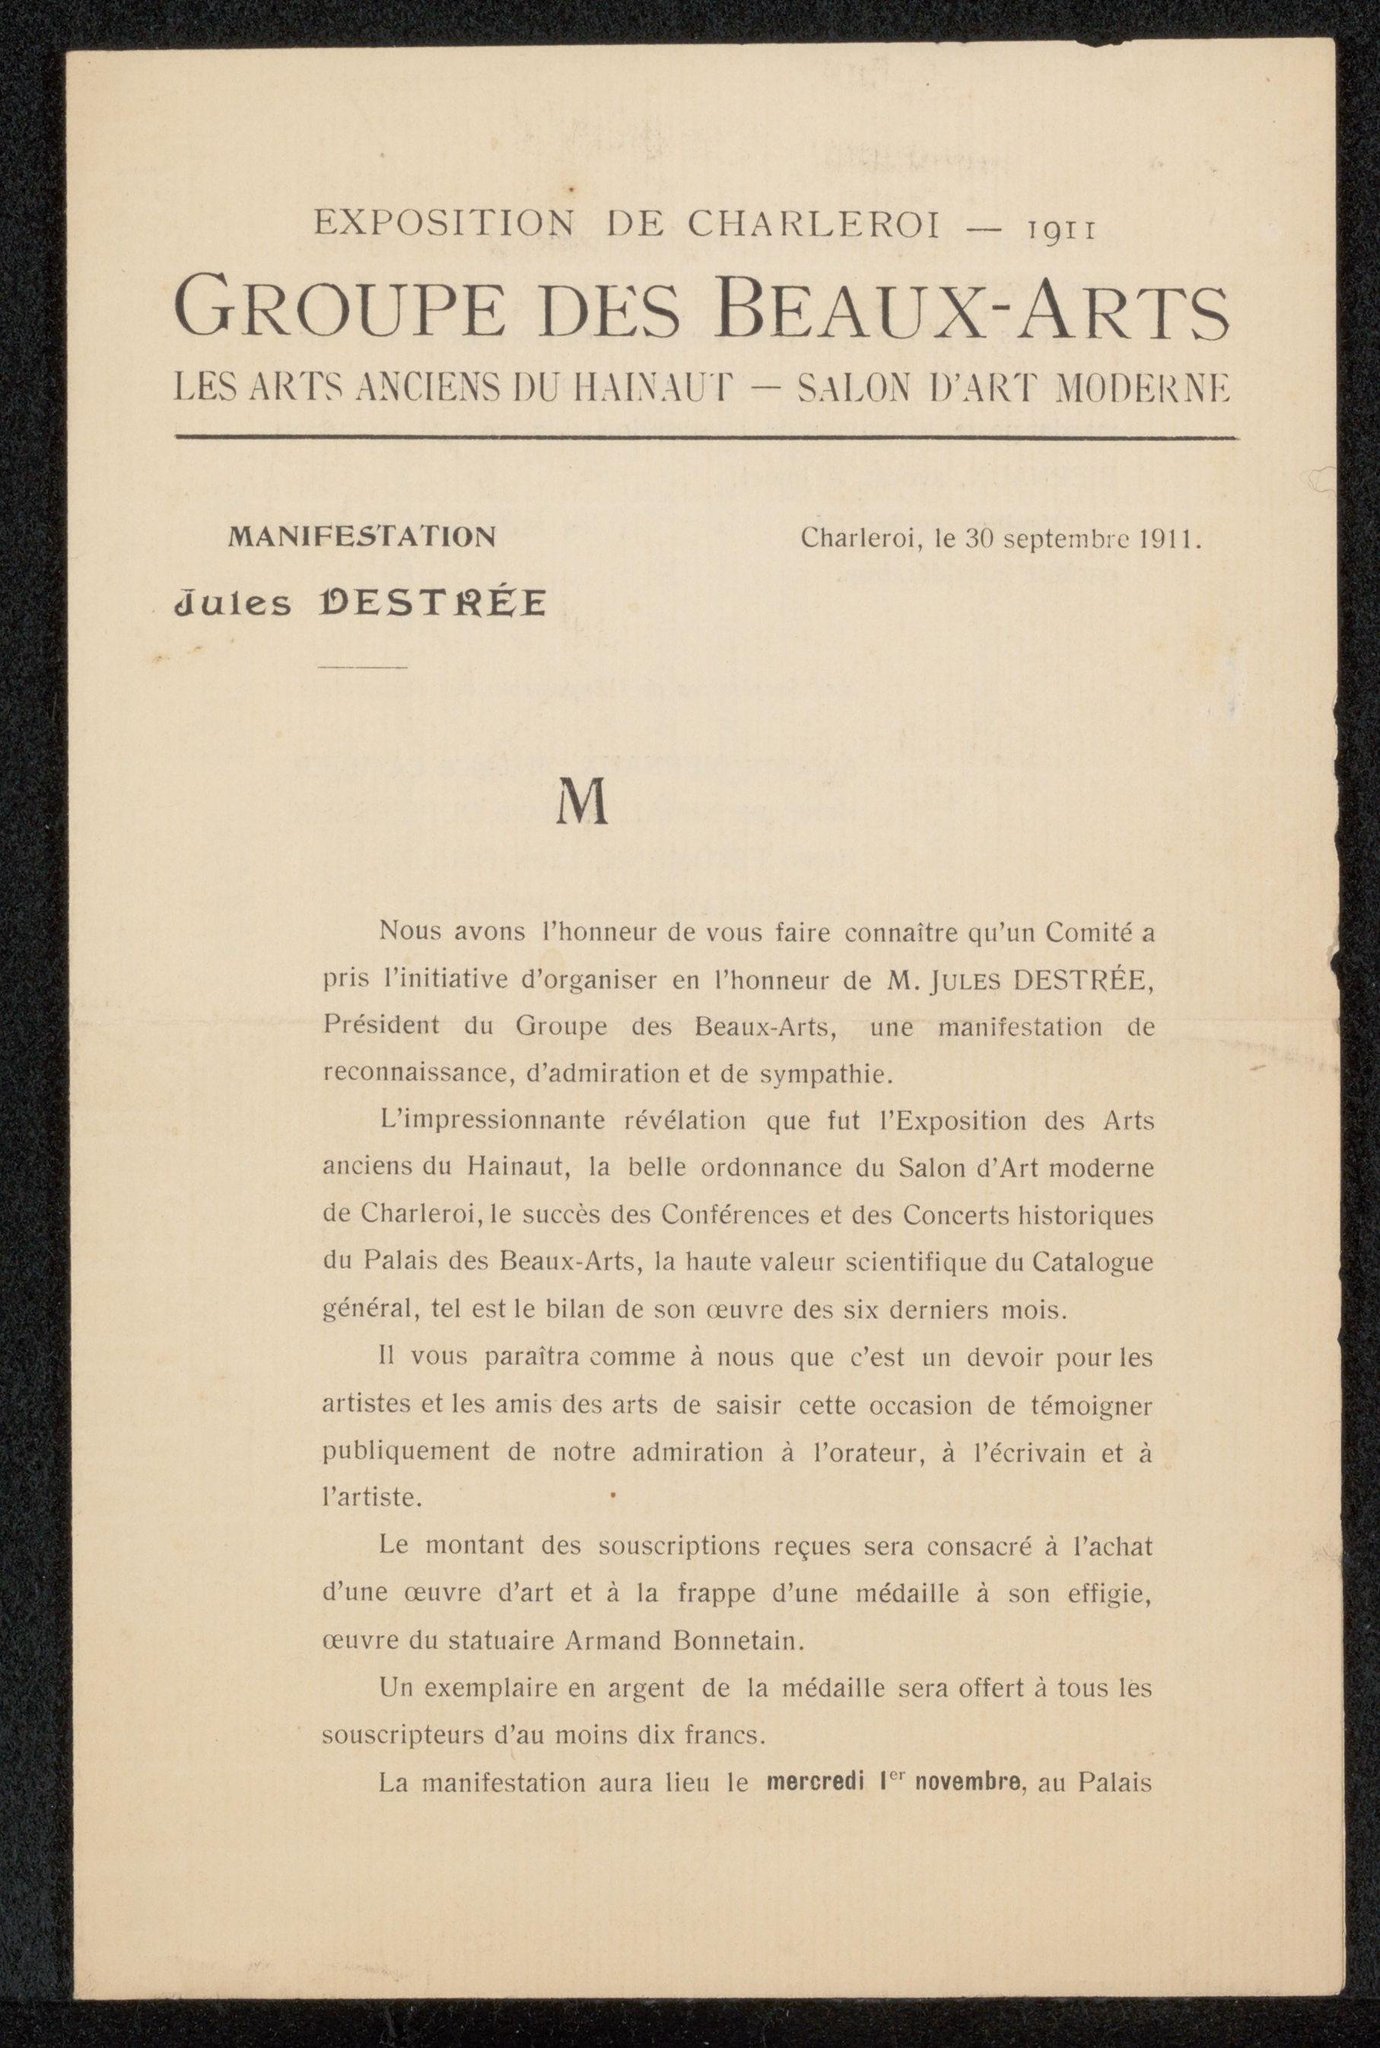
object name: folder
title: Folder uit archief Philip Zilcken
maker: auguste joseph biernaux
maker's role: bierbrouwer, wethouder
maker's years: 1811-1876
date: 1911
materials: paper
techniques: printing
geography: charleroi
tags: politician, jules destrée, the hague, painter, philip zilcken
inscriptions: collector's mark: ‘RPK’